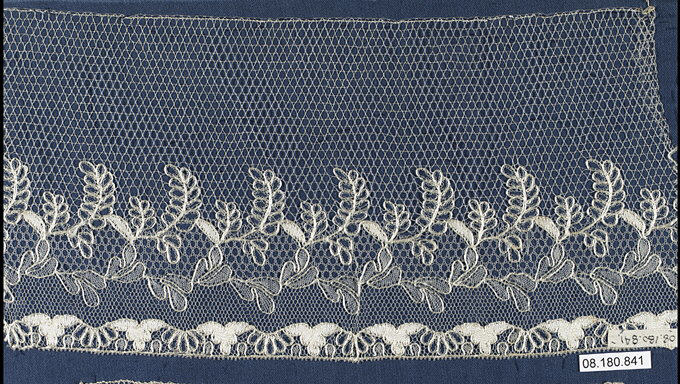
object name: fragment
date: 1801-1900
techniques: lace